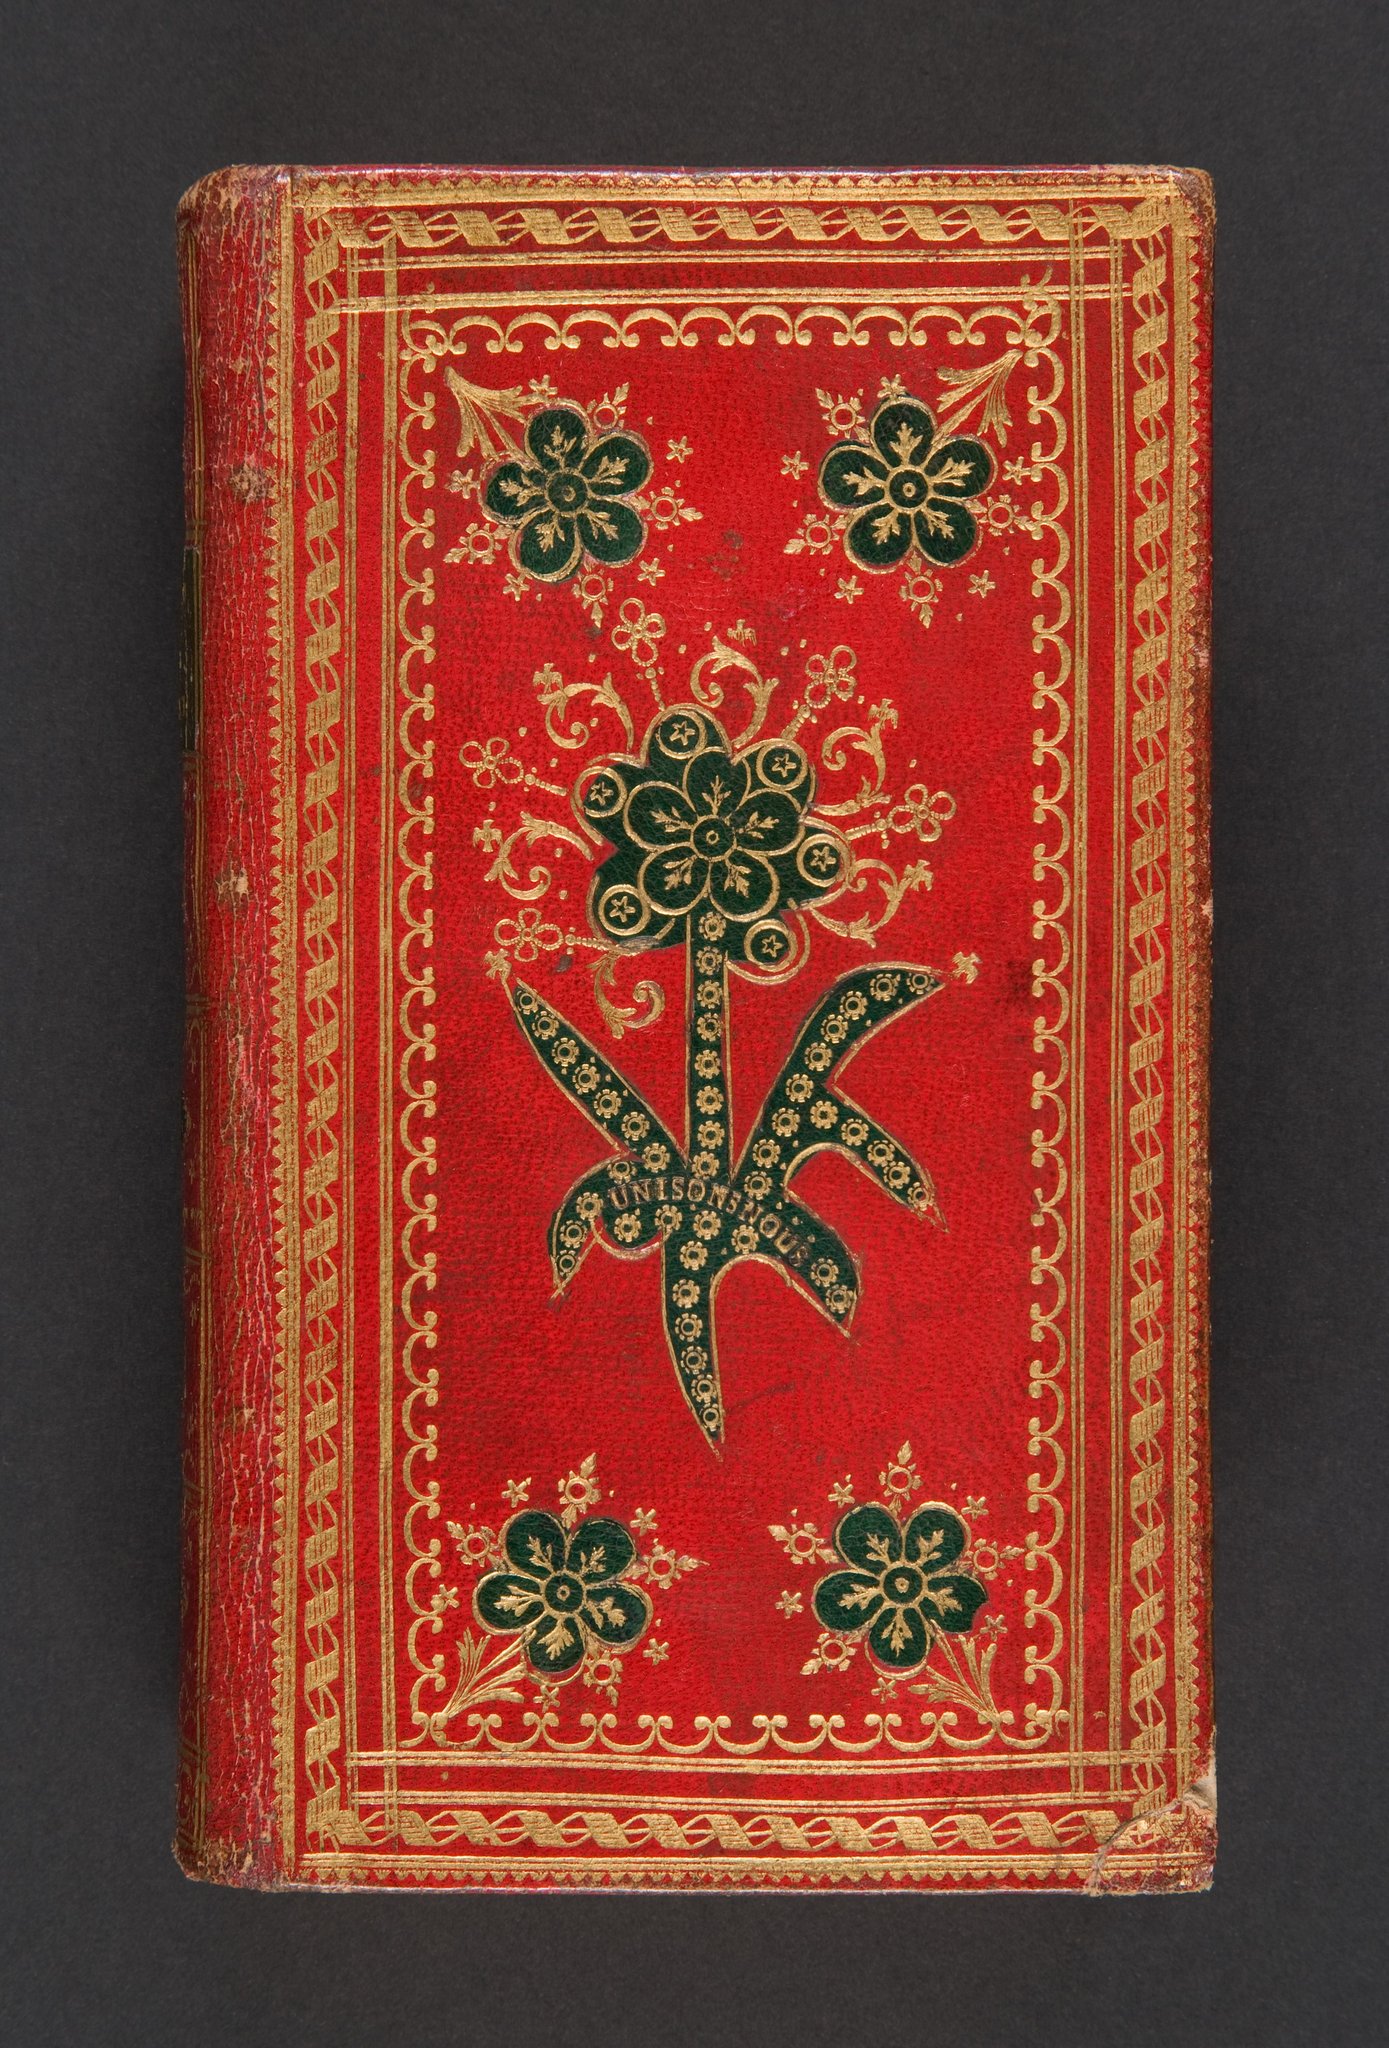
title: L'office de l'Église en françois contenant les offices pour toute l'année, plusieurs prières tirées de l'écriture-sainte & des saints pères, les hymnes en vers françois, avec une instruction pour les fidèles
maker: catholic church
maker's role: author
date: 1792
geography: france